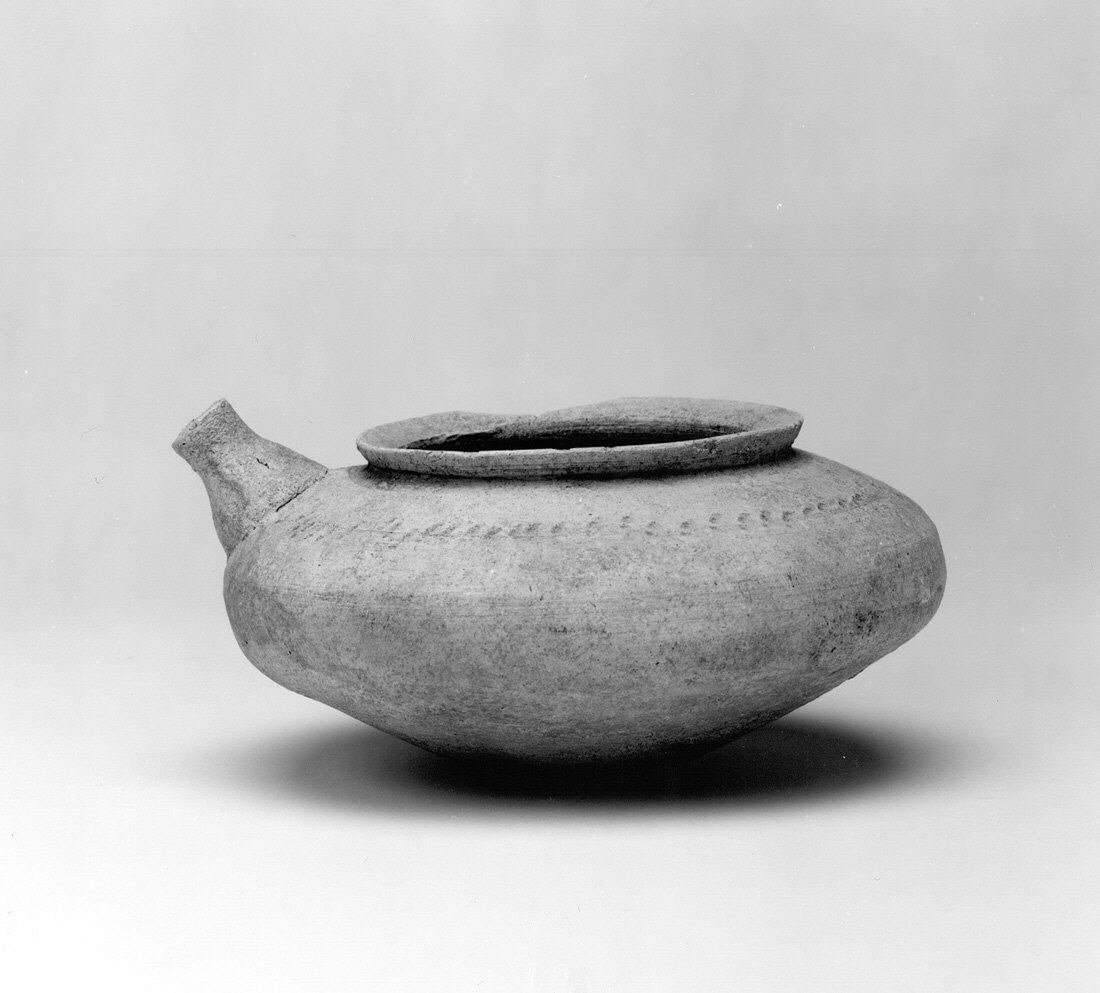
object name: jar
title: Jar with a spout and punctate decoration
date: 3300-3100 BCE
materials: ceramic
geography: mesopotamia or syria